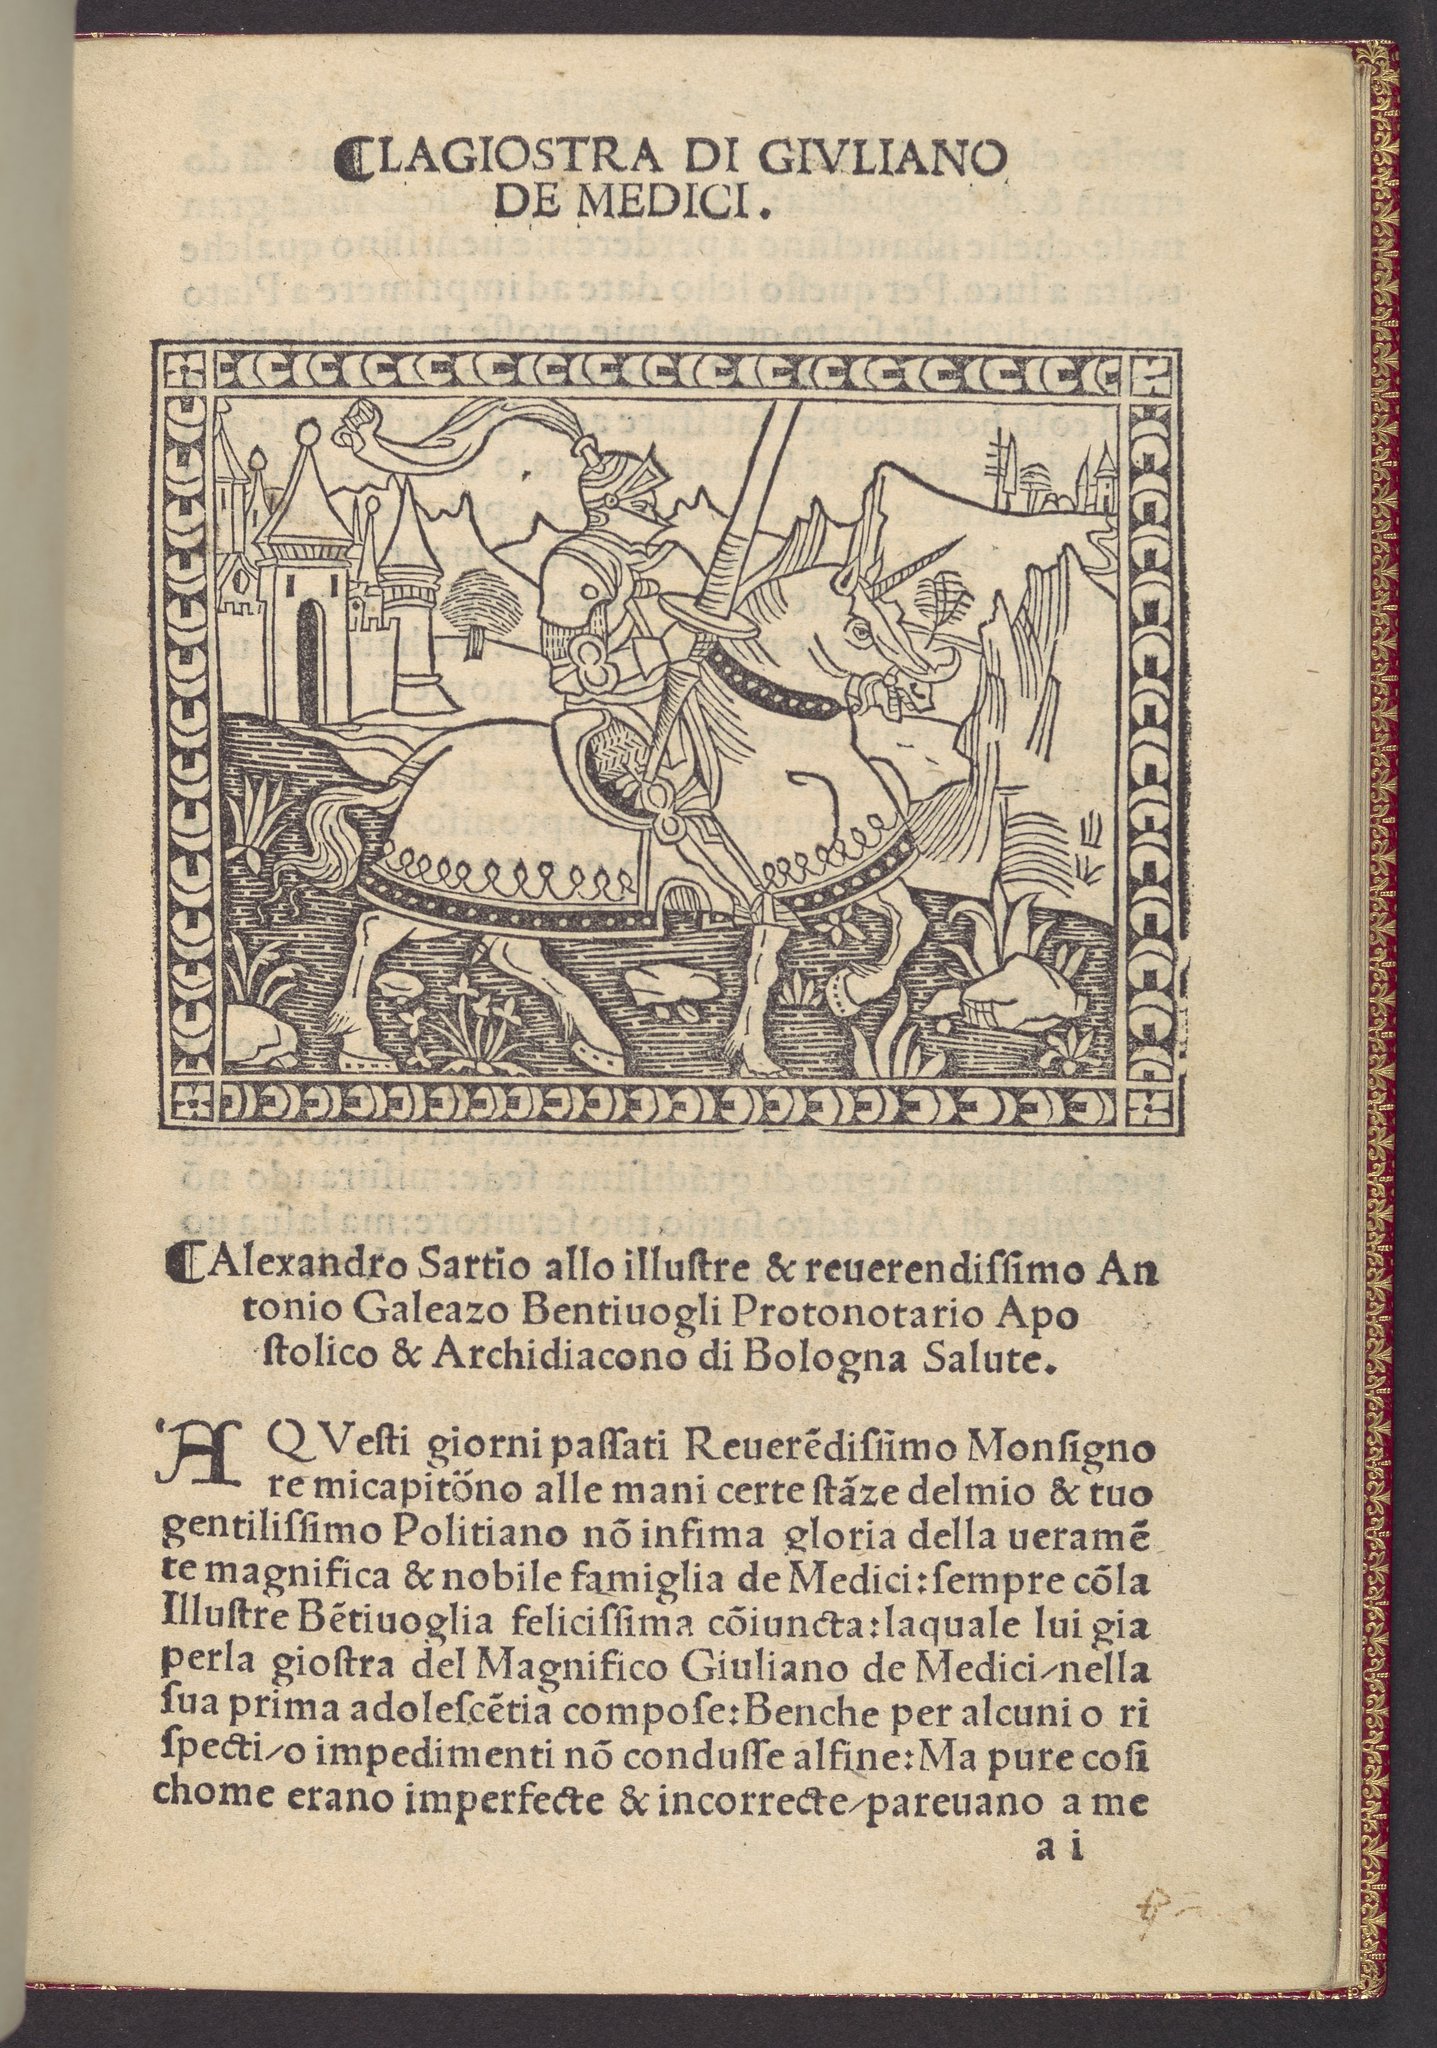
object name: book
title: La Giostra di Giuliano de Medici...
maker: angelo poliziano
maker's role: author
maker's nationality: italian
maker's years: 1454-1494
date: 1495-1500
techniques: printing, woodcut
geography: florence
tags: men,horses